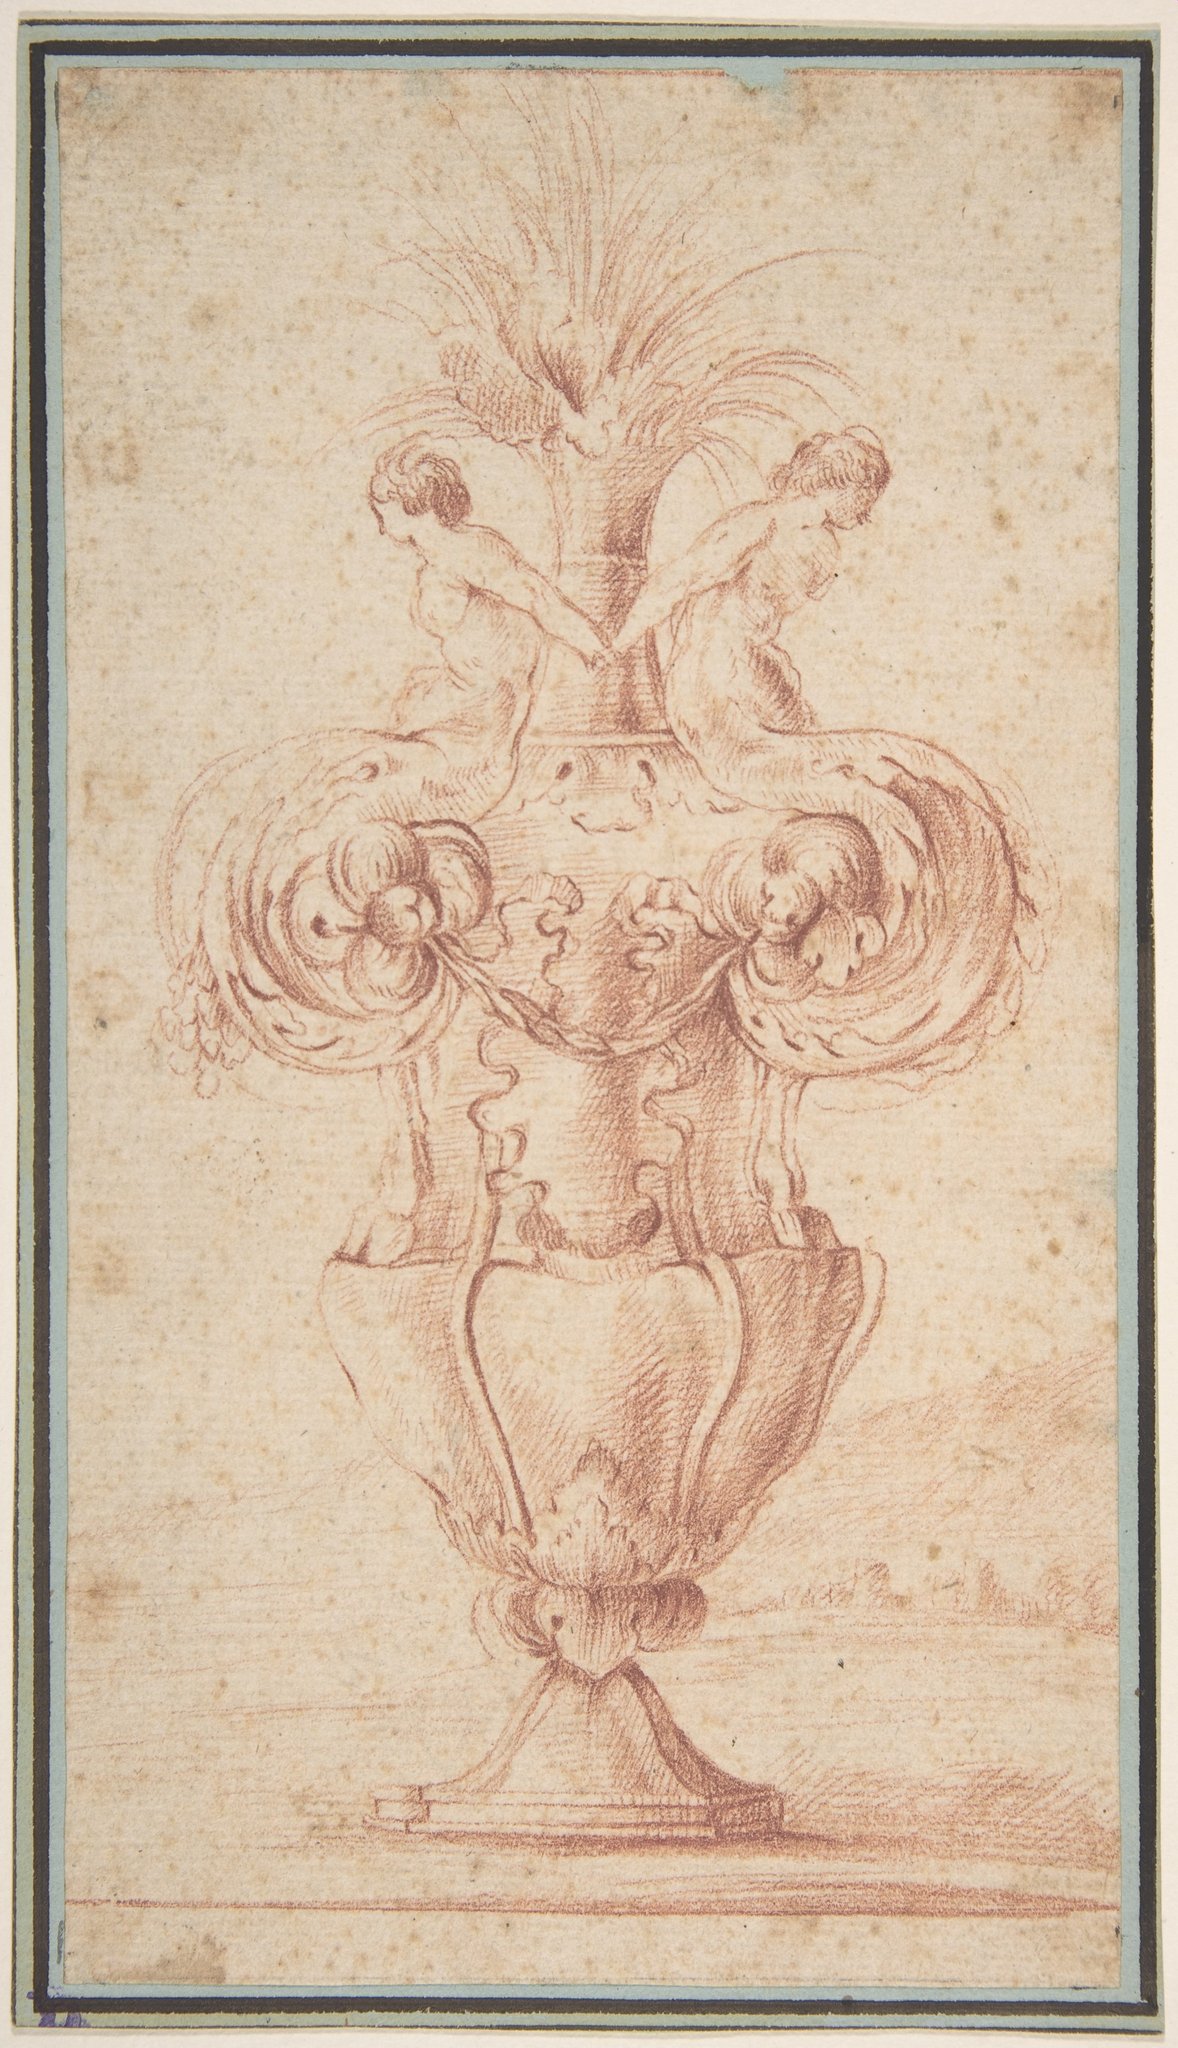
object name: drawing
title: Vase with Two Female Hybrid Figures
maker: anonymous, french, 18th century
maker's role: artist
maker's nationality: french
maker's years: 1700-1800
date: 1701-1800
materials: ink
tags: vases